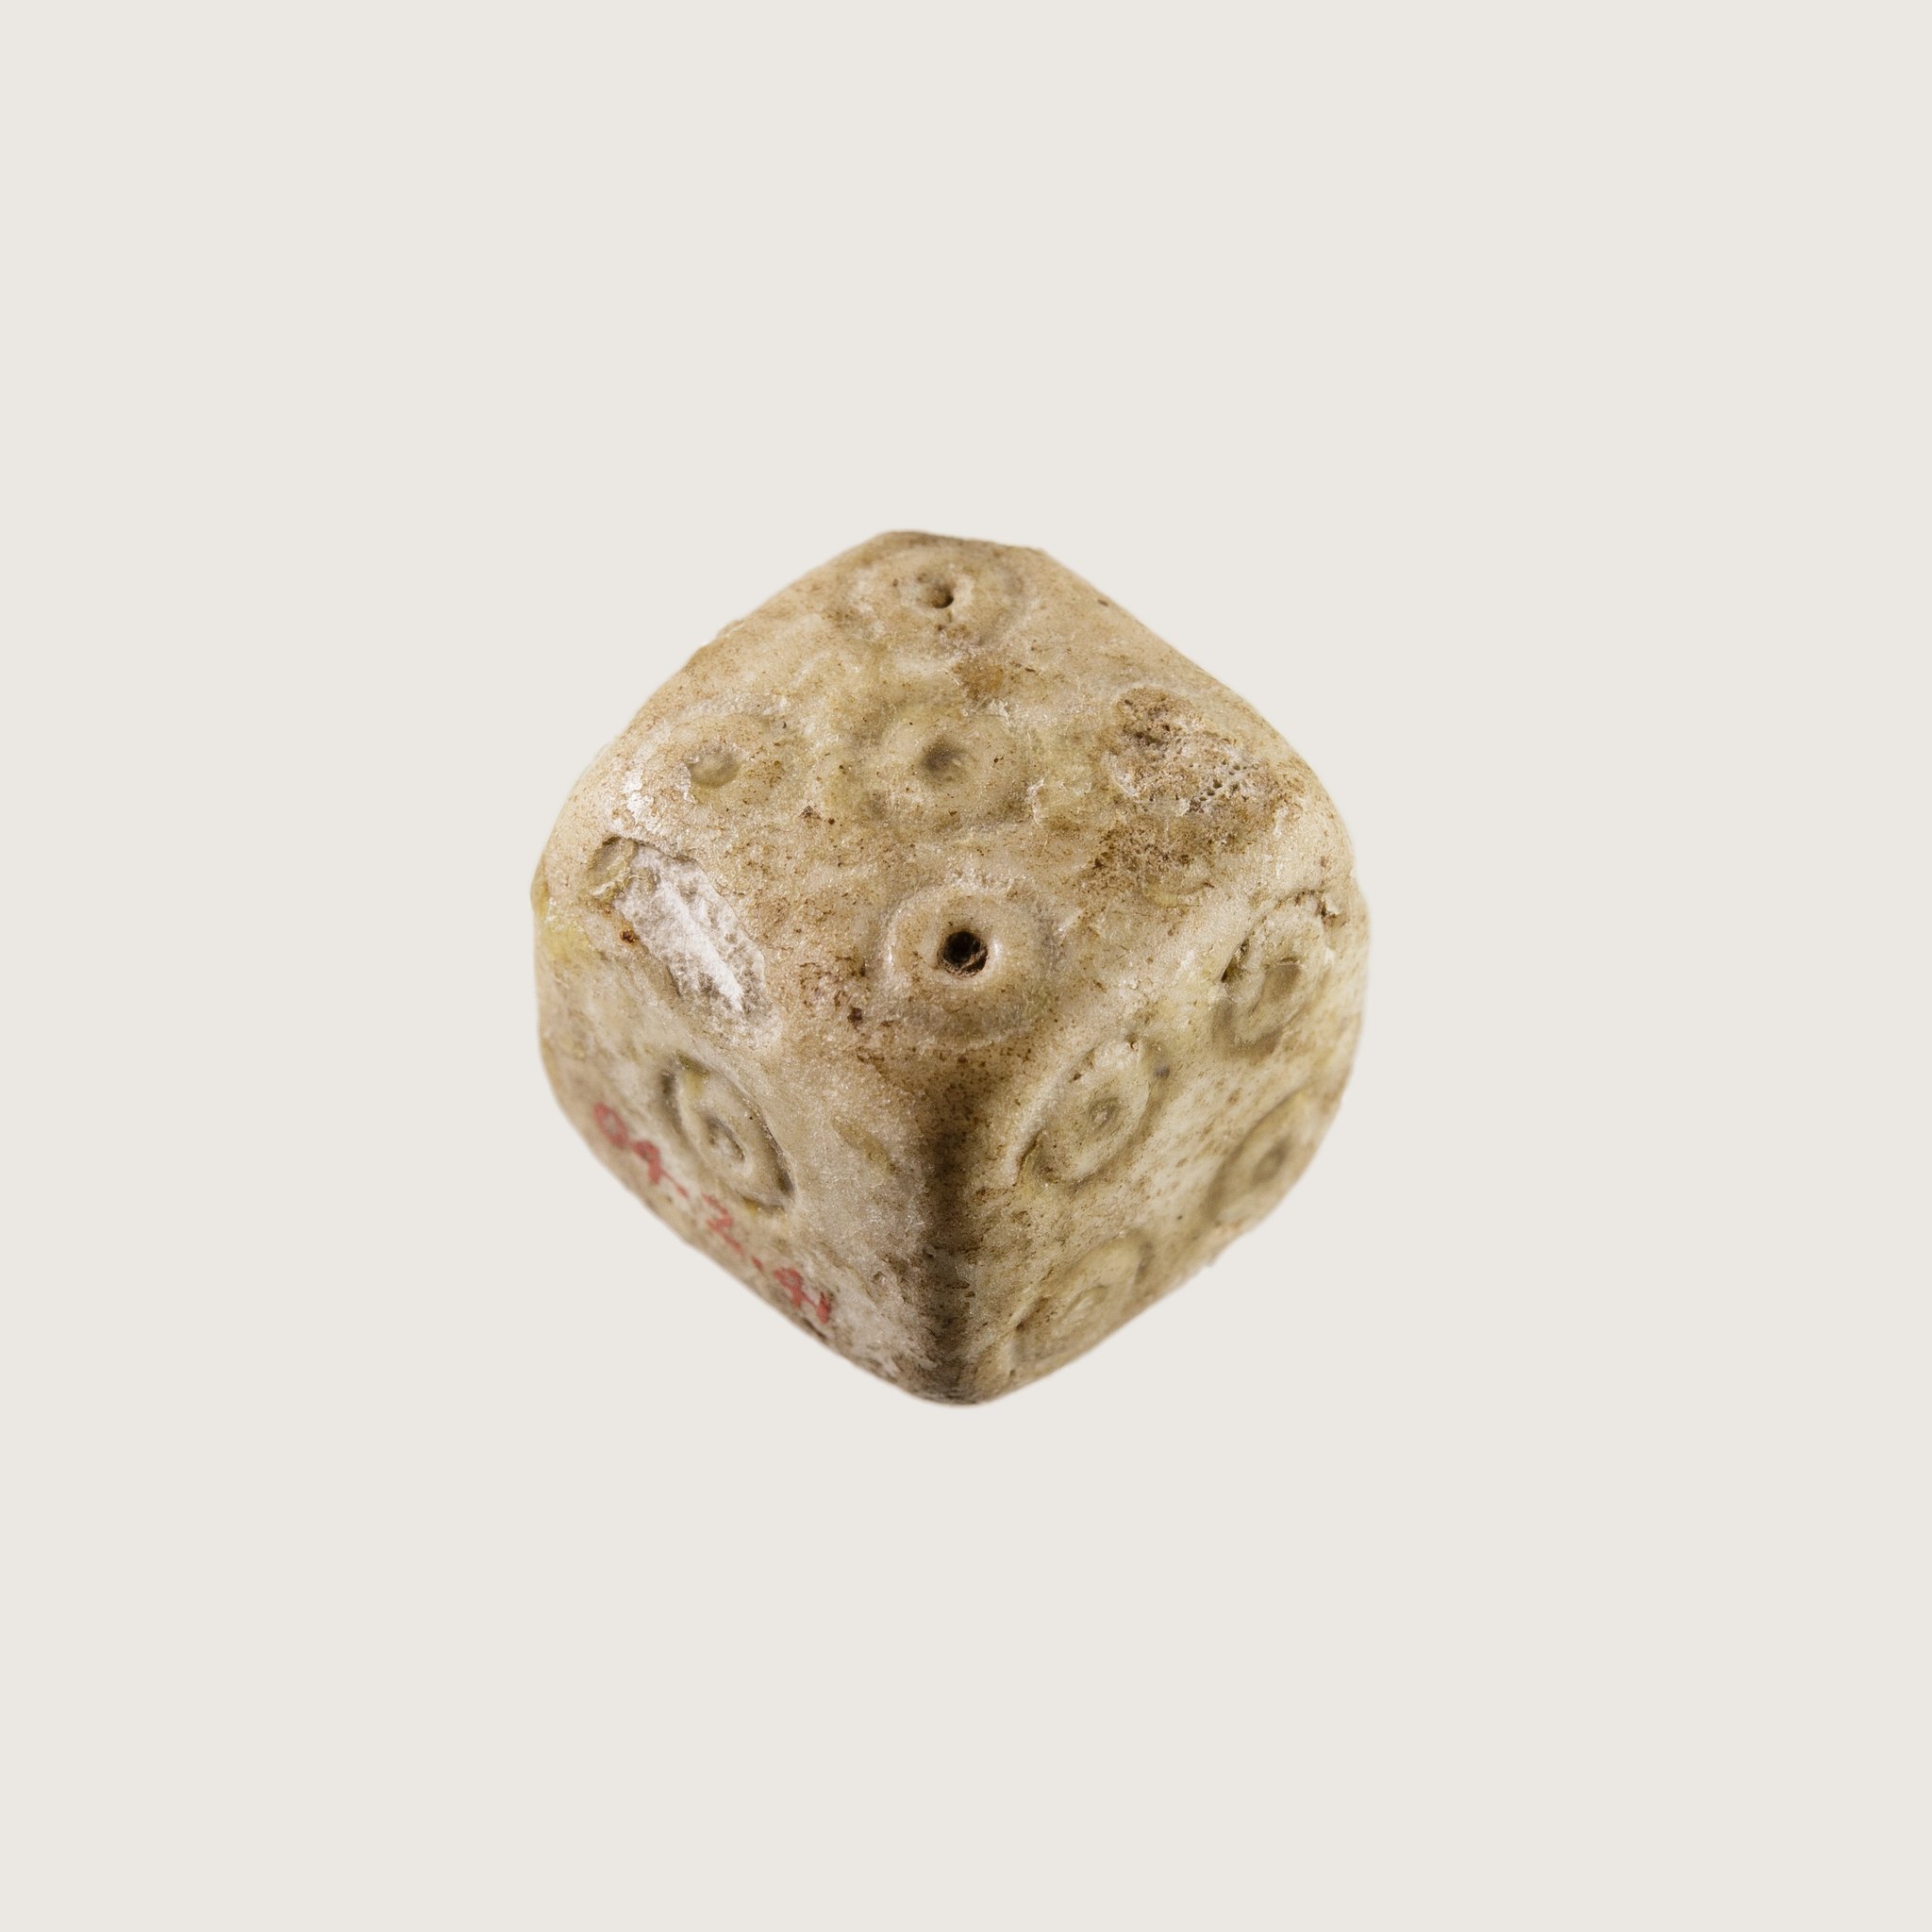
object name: die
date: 332-330 BCE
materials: faience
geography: egypt